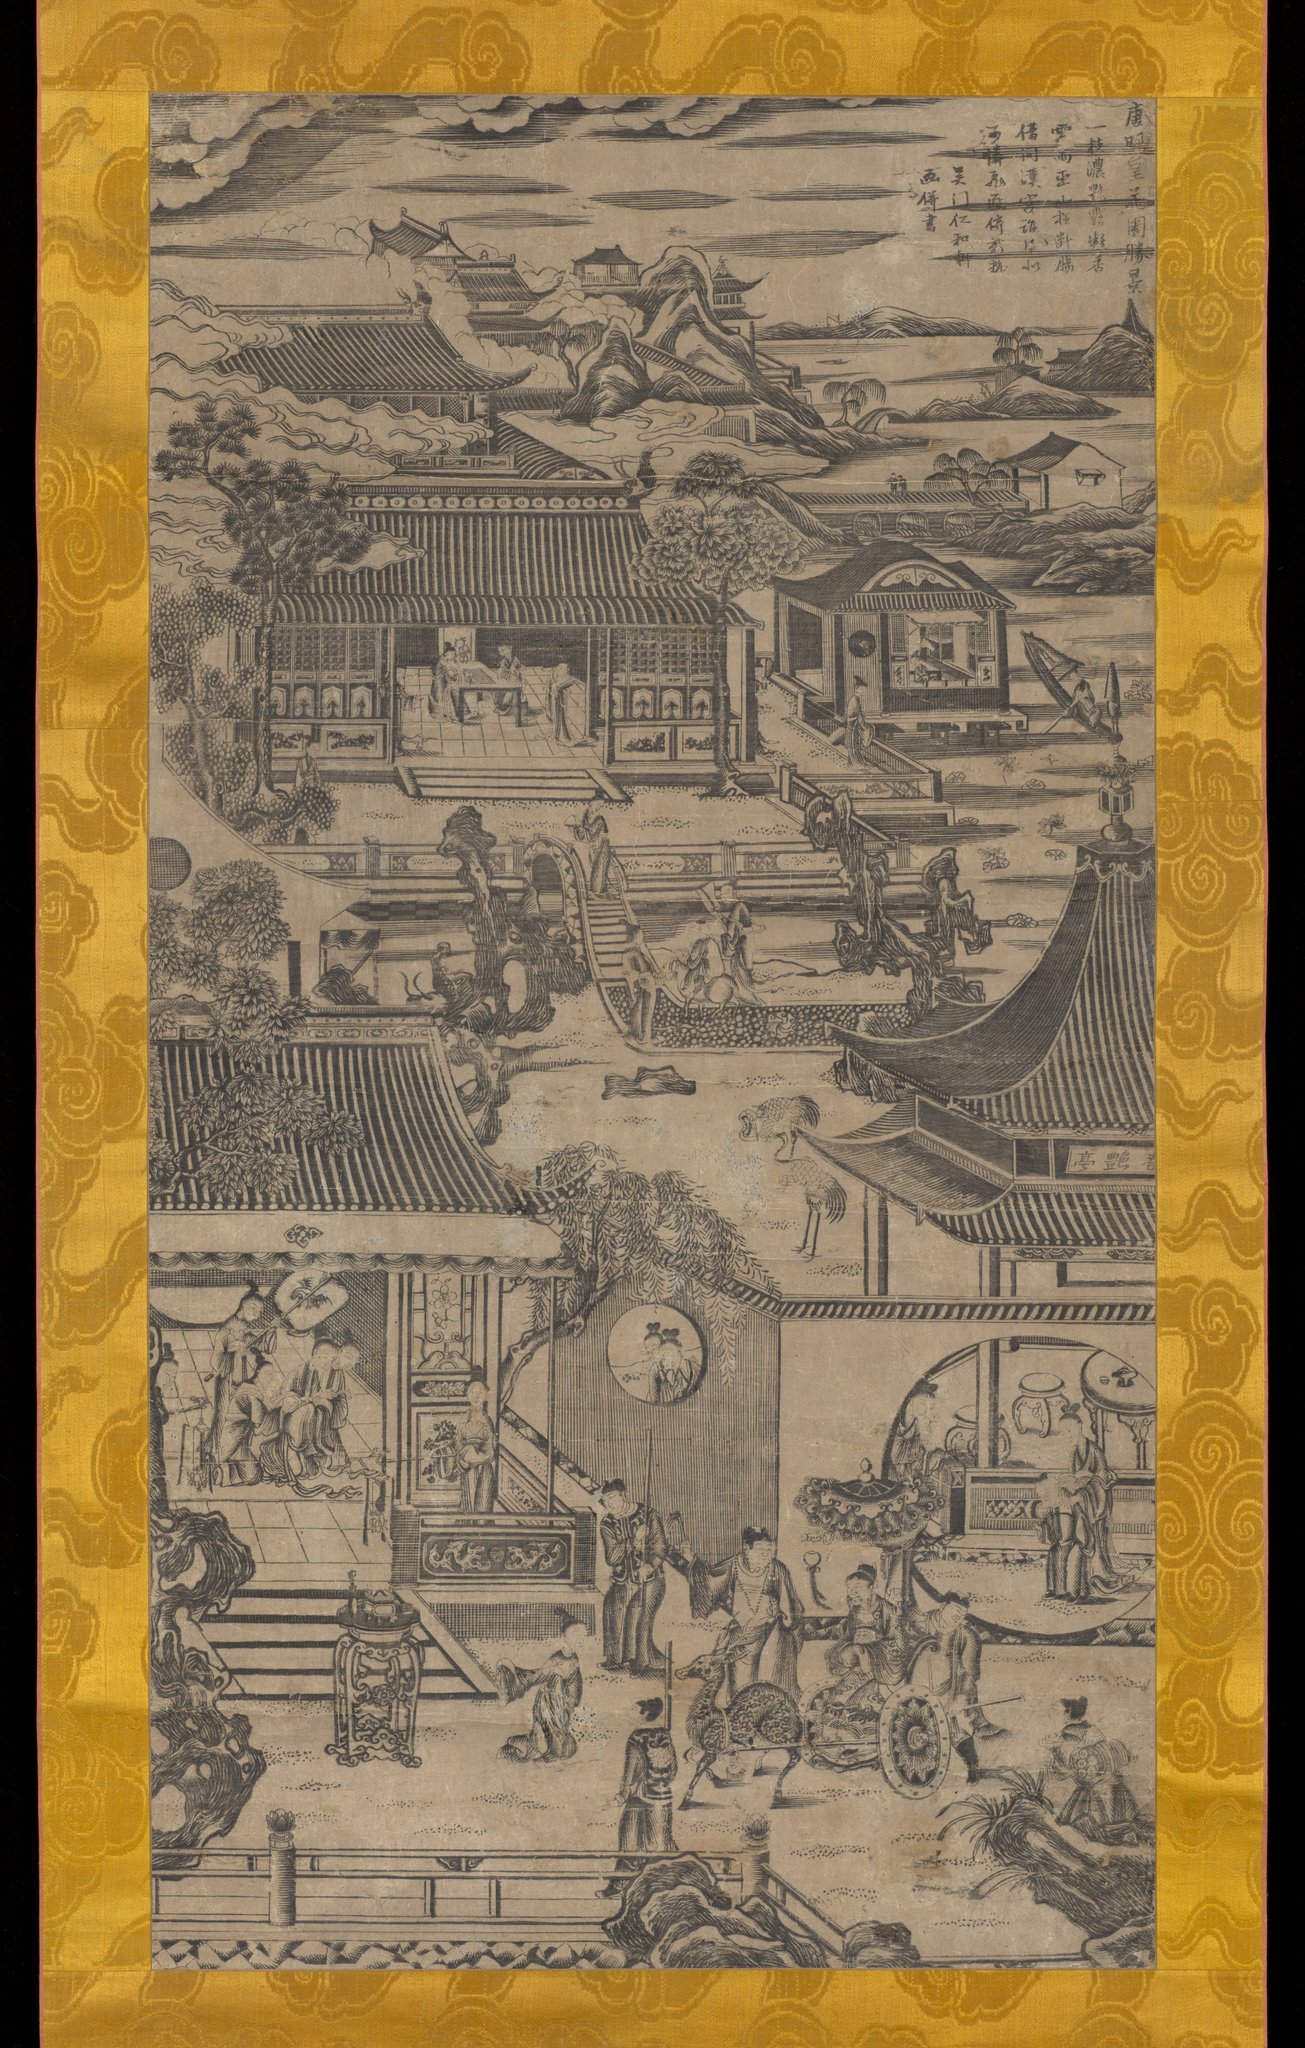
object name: print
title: A Scenic View of Minghuang’s Gardens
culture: chinese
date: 1736-1795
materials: ink, paper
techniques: woodblock print